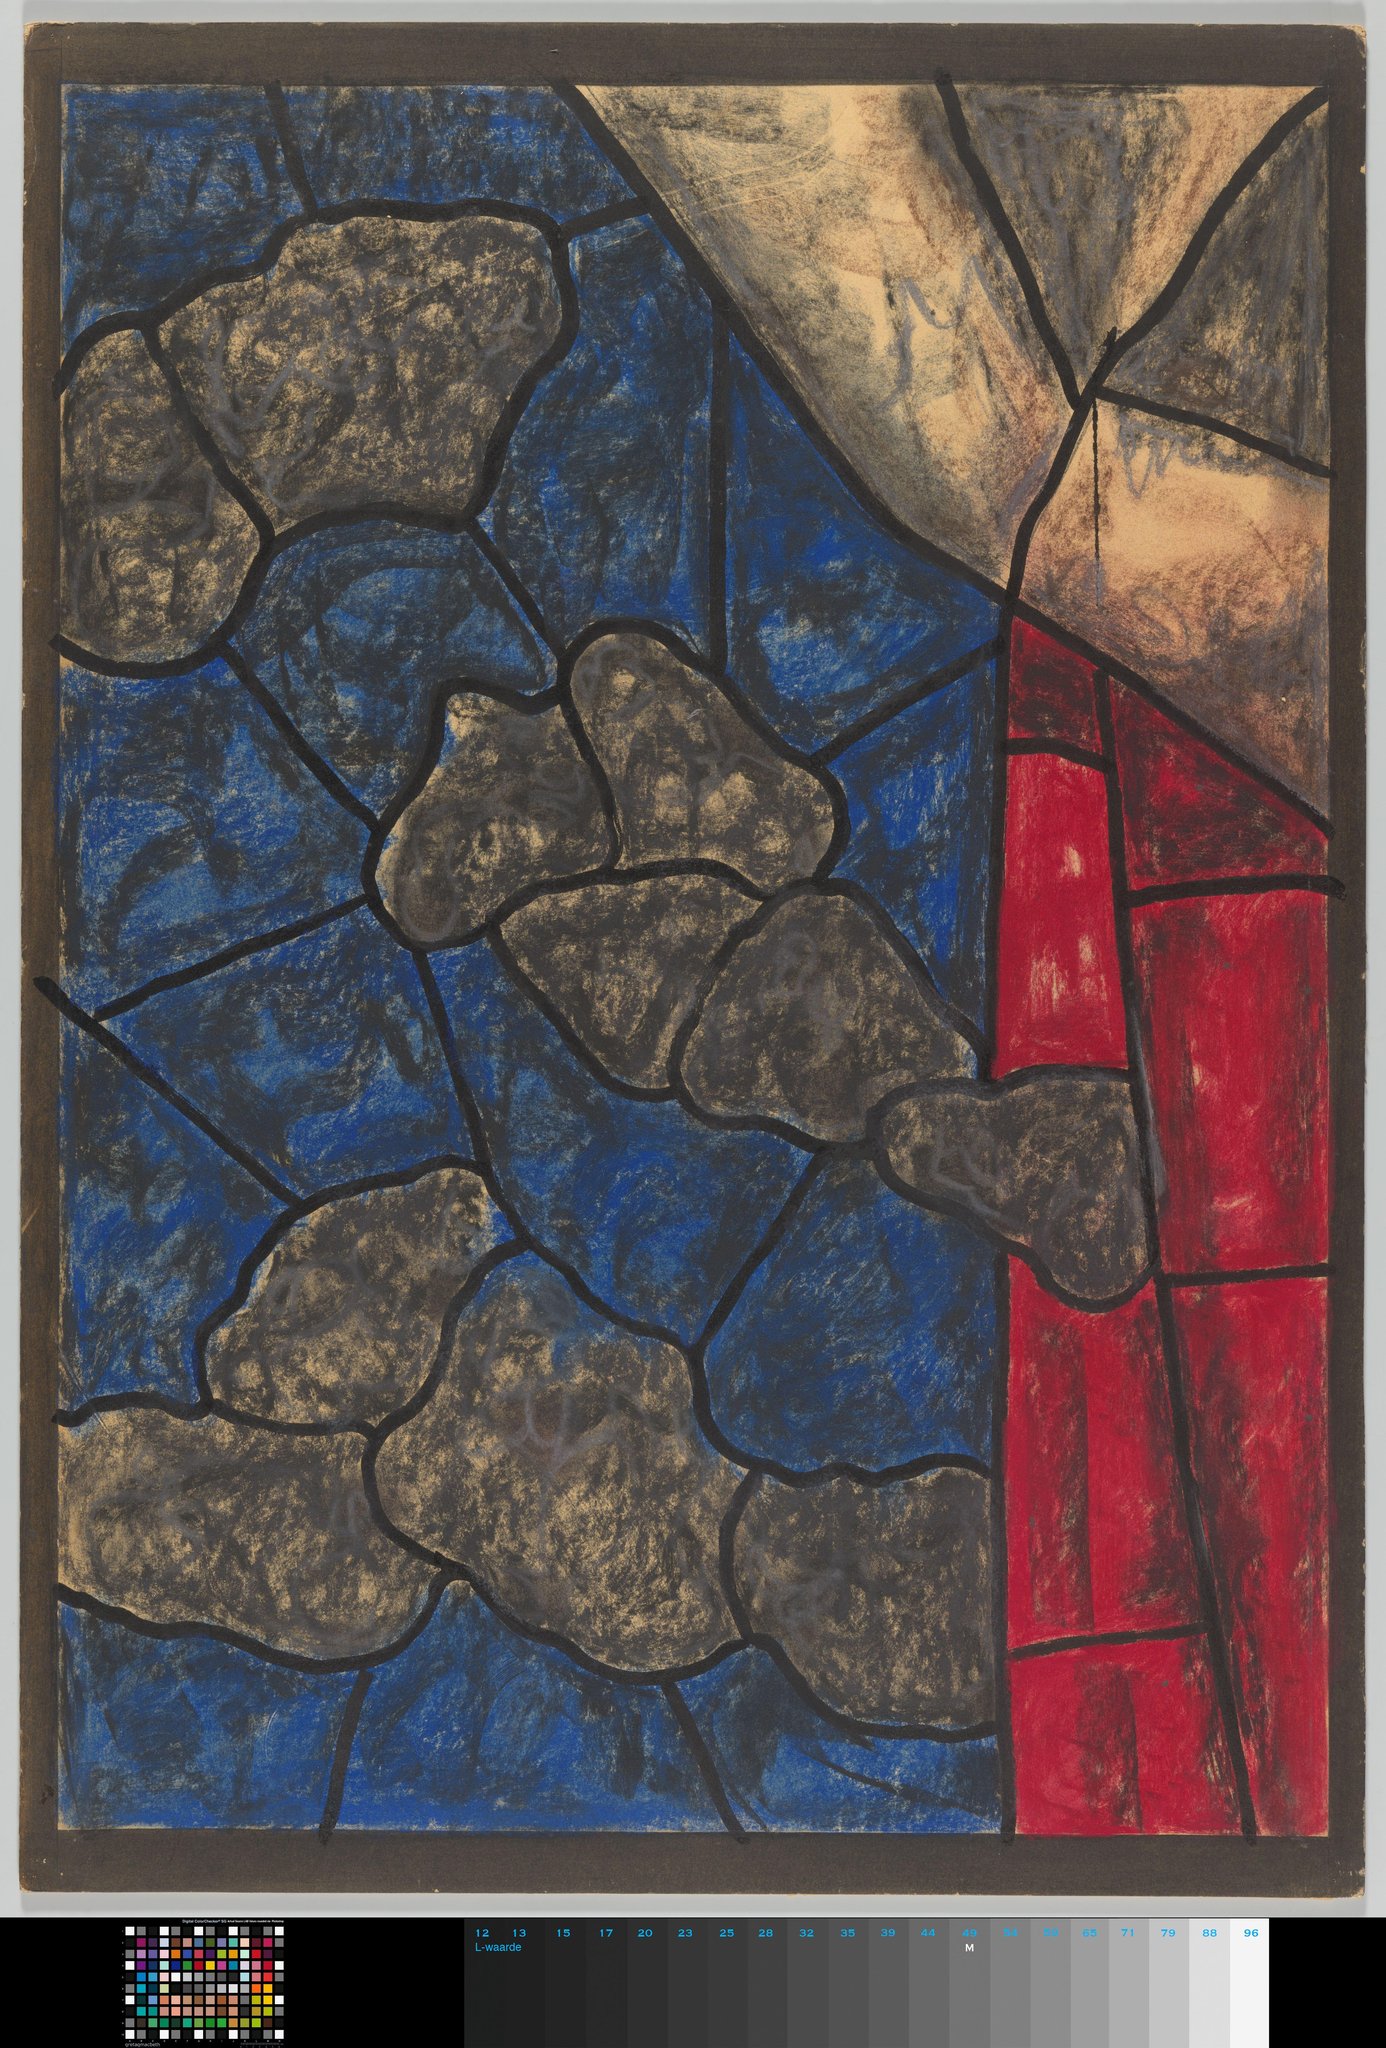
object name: drawing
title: Ontwerp voor raam in het Noordertransept in de Dom te Utrecht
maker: richard nicolaüs roland holst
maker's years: 1868-1938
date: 1934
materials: cardboard, chalk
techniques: brush